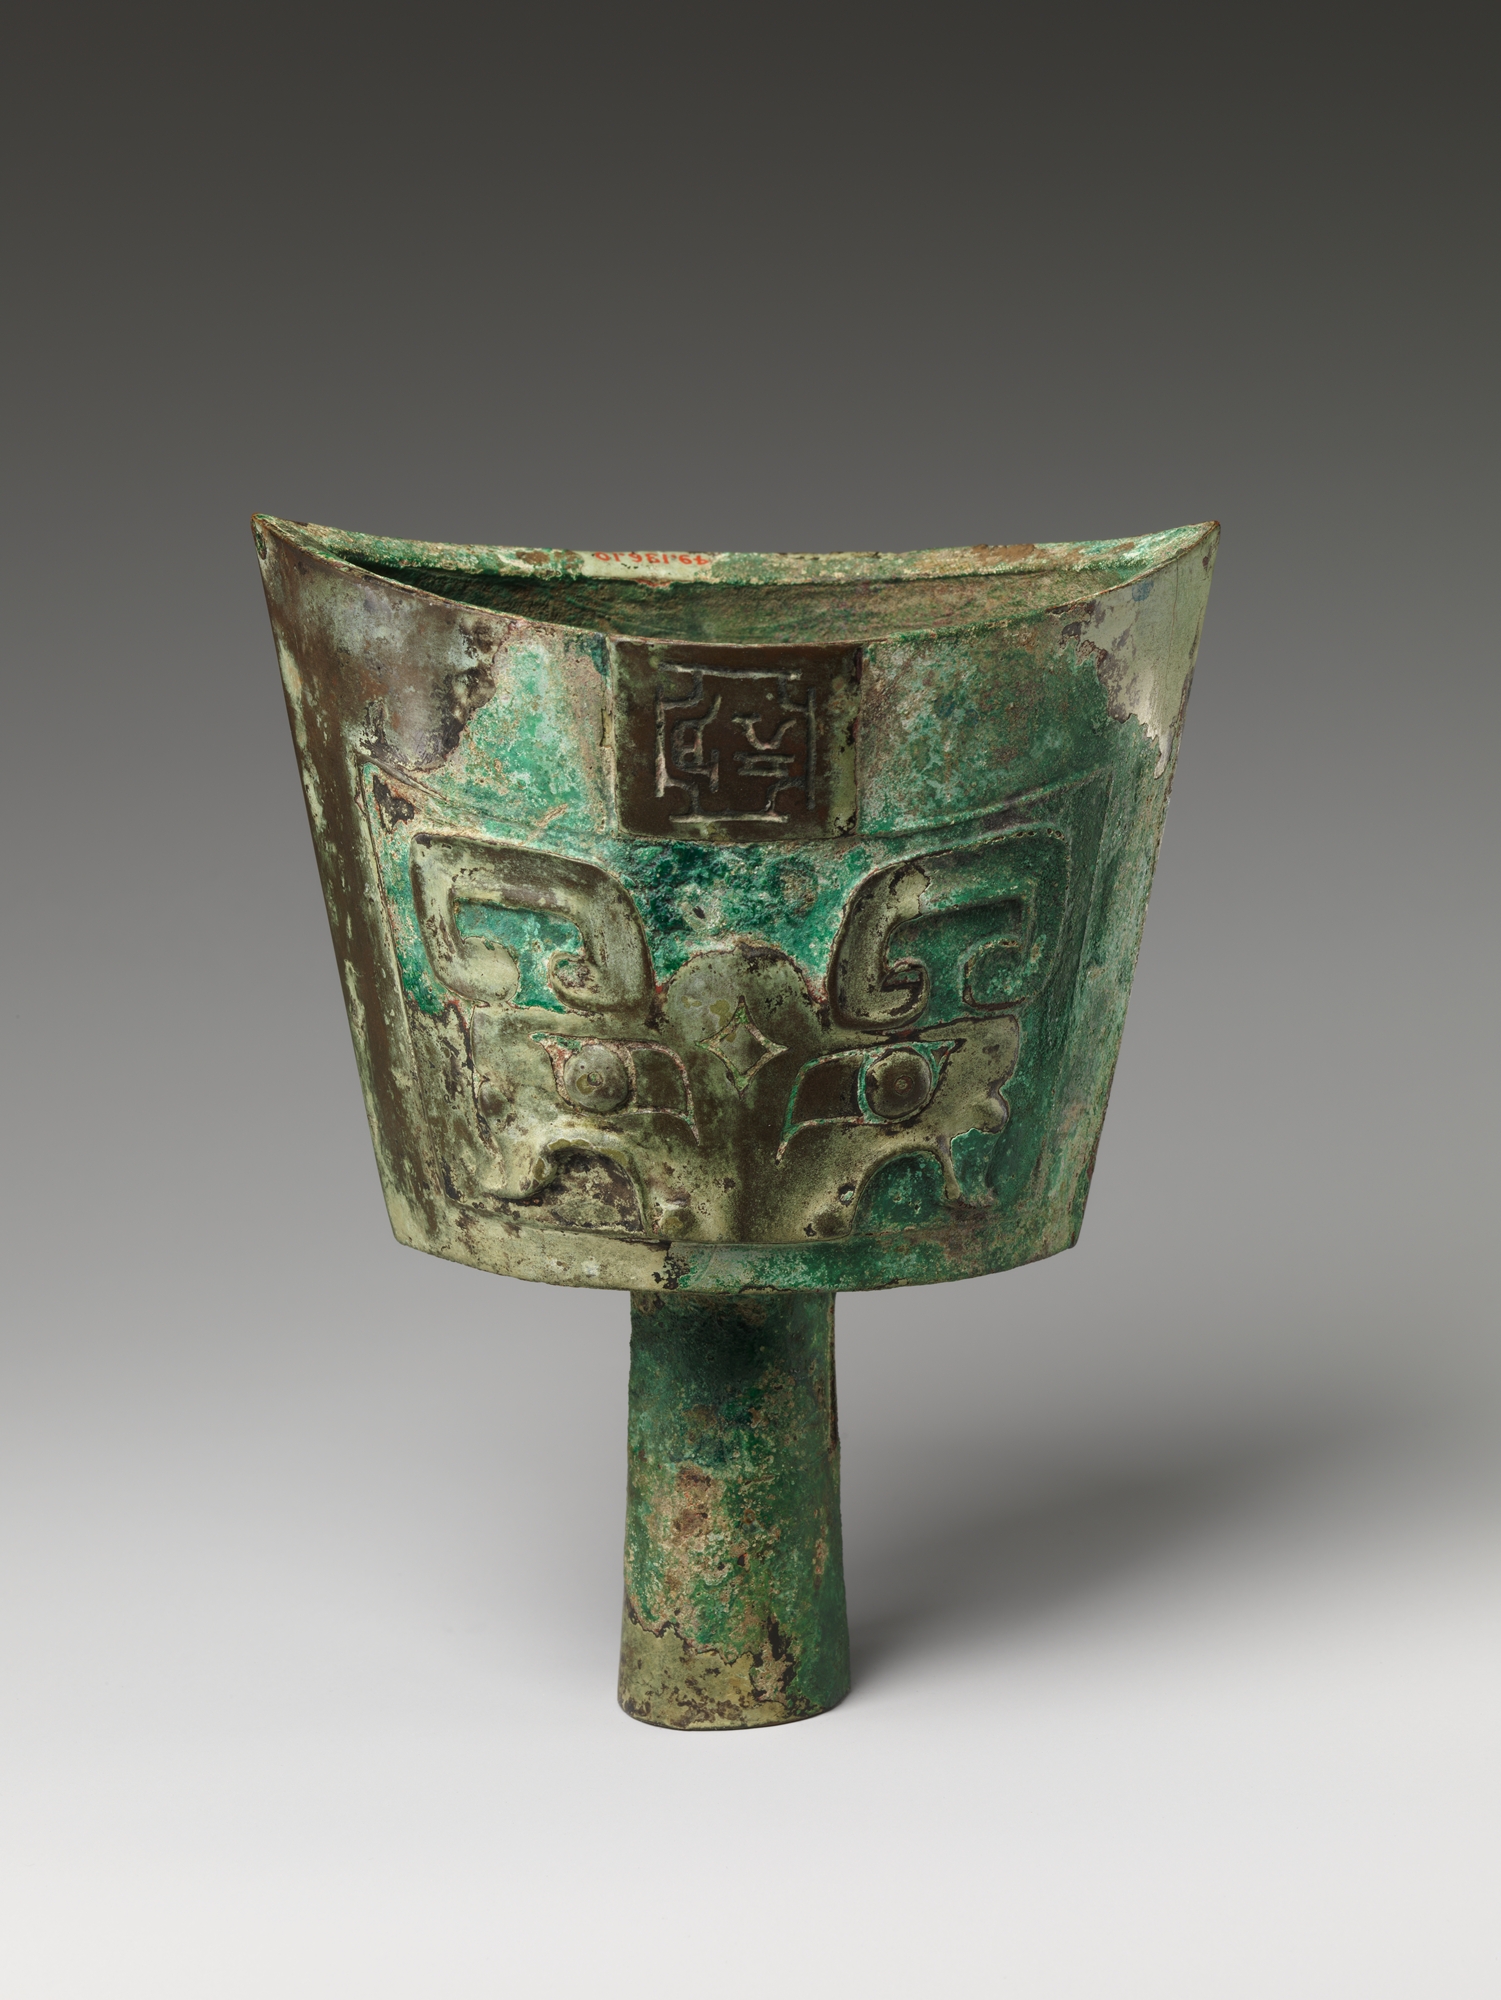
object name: bell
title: Upright bell (nao)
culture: chinese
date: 1300-1201 BCE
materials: bronze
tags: musical instruments